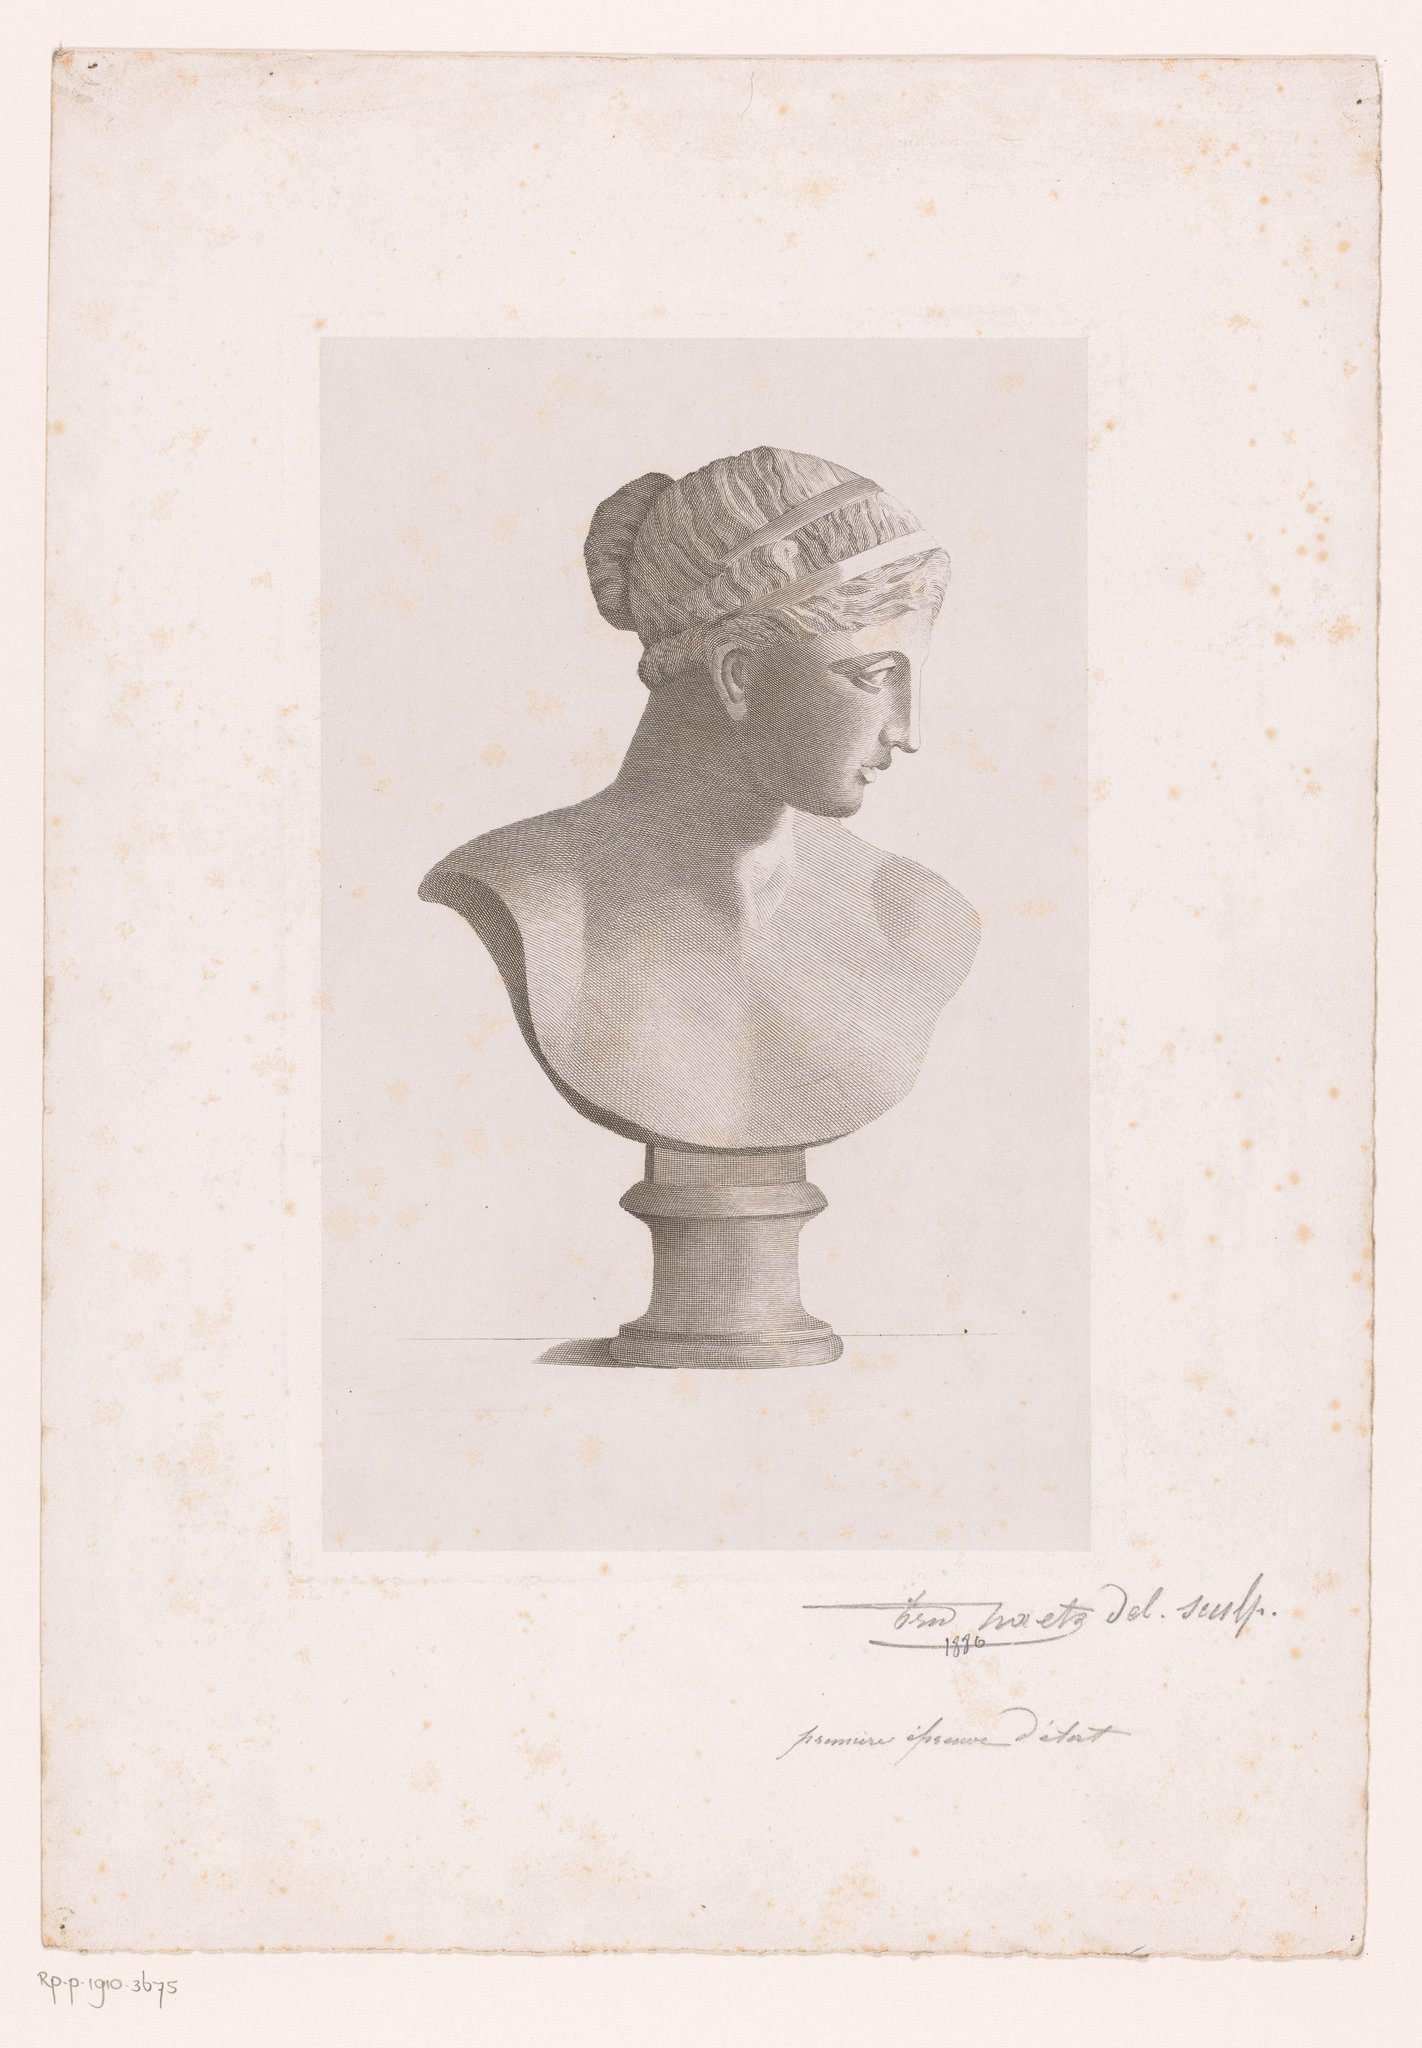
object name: print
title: Marmeren buste van een vrouw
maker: ernest haets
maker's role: print maker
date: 1886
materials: paper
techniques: engraving, etching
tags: chest, bust - aa - female human figure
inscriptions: annotation: ‘premiere épreuve d'etat’, collector's mark: Lugt 2228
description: Sterfdatum prentmaker onbekend. Derhalve zijn voor bepaling van de rechten van dit object de vervaardigings- en verwervingsdatum aangehouden.